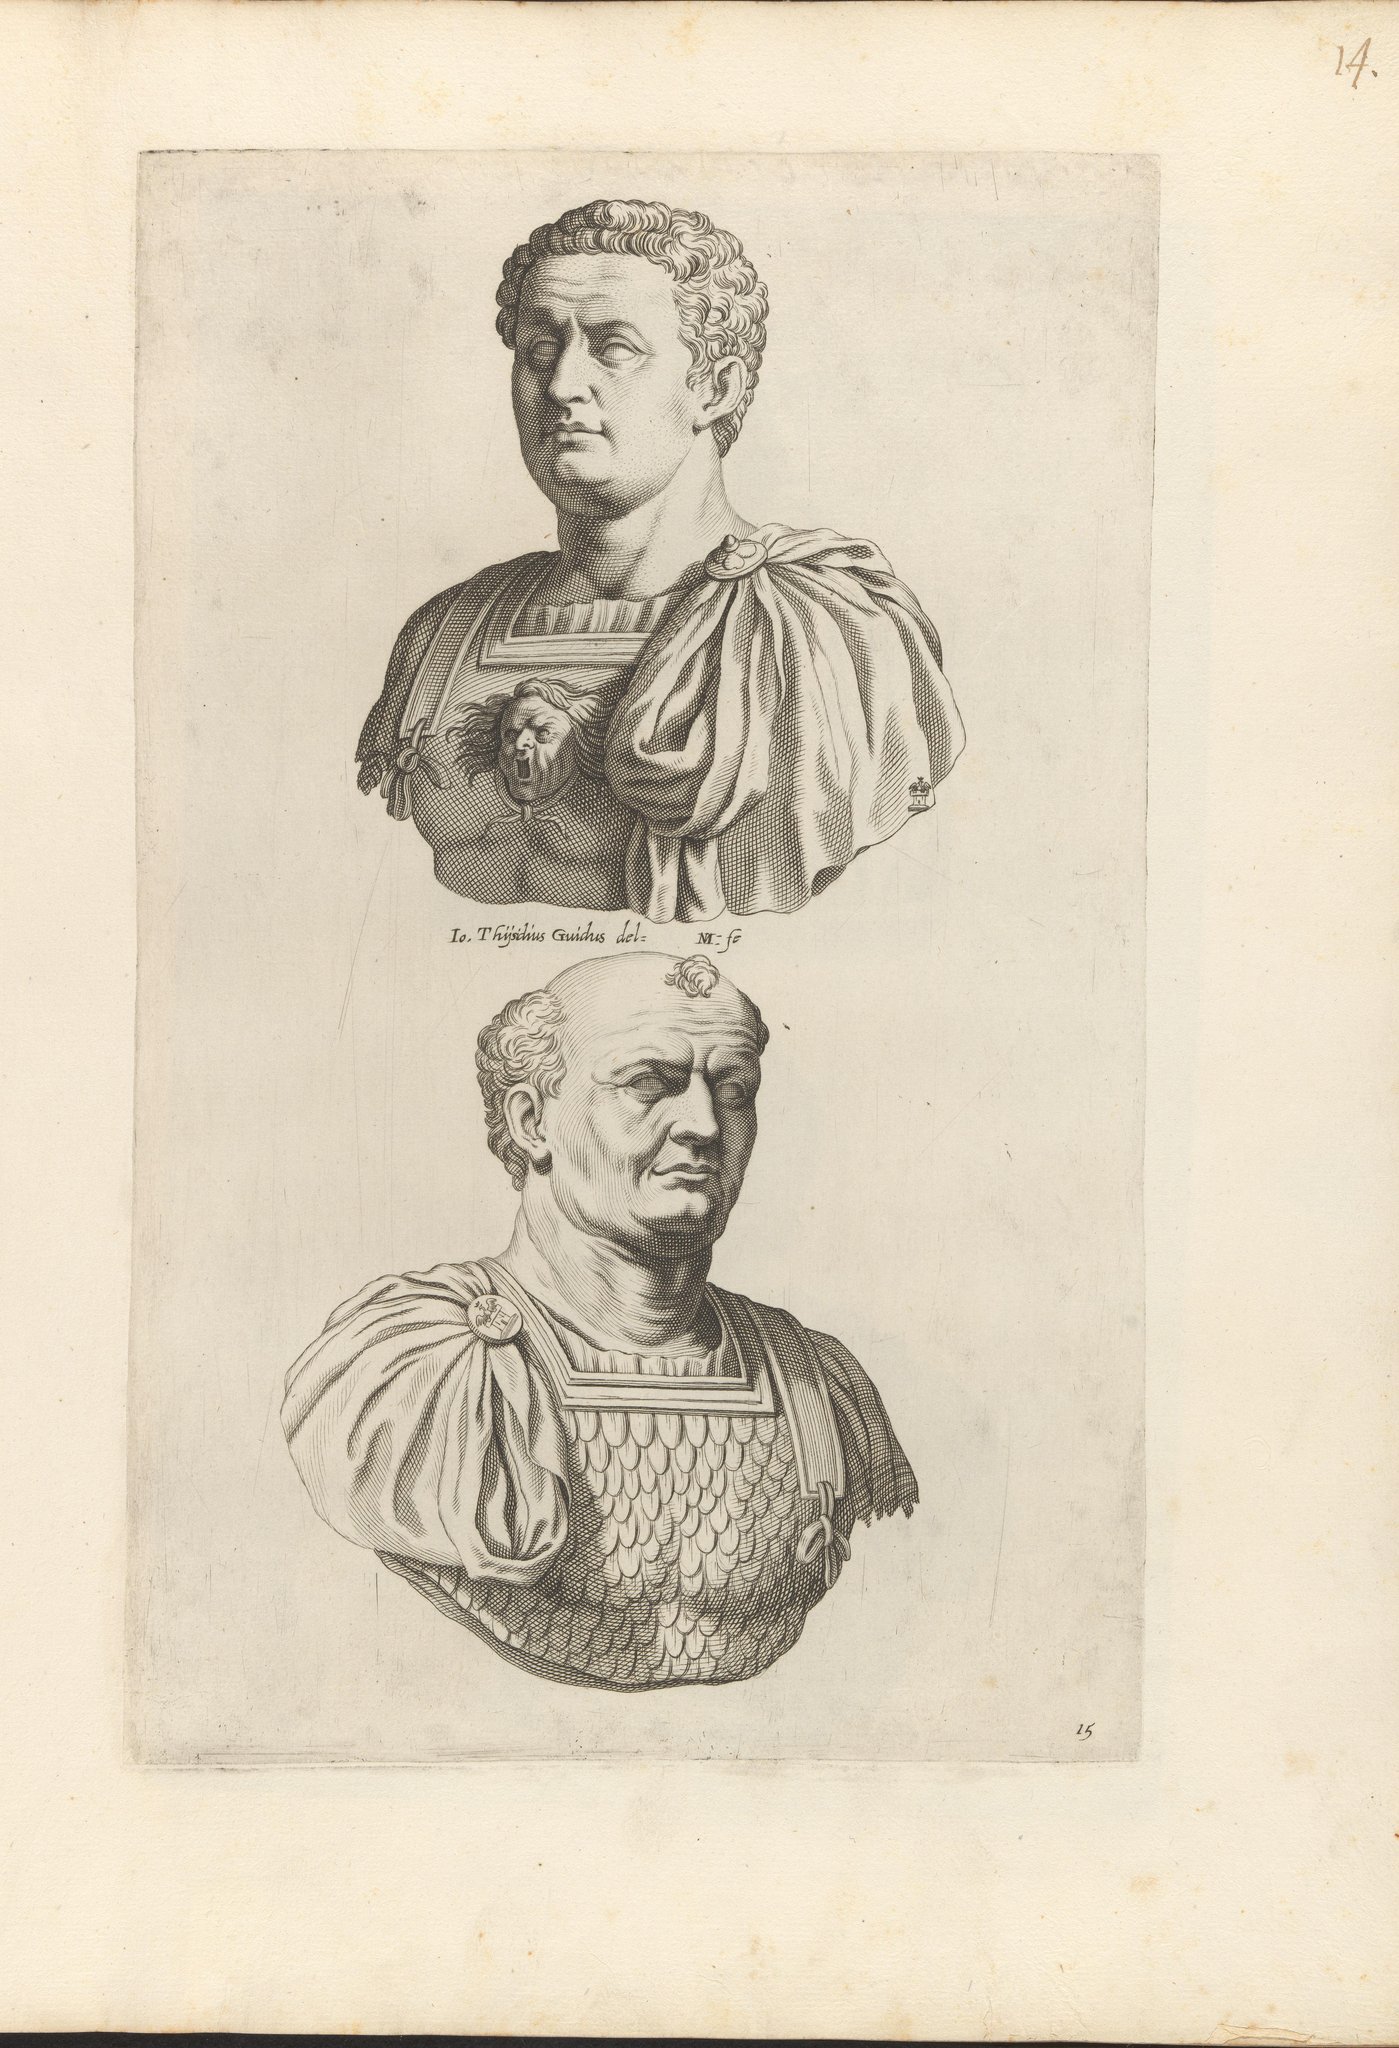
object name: print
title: Portretbustes van Titus en Vespasianus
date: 1636-1647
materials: paper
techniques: engraving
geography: rome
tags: male persons from classical history (+ head, bust, etc.), piece of sculpture, reproduction of a piece of sculpture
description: Portretbustes van Romeins keizer Titus en Rmeins keizer Vespasianus. Op de onderste buste het wapenschild van Vincenzo Giustiniani. Prent maakt deel uit van een album met een serie prenten naar de sculpturen in de verzameling in de Galleria Giustiniani te Rome.